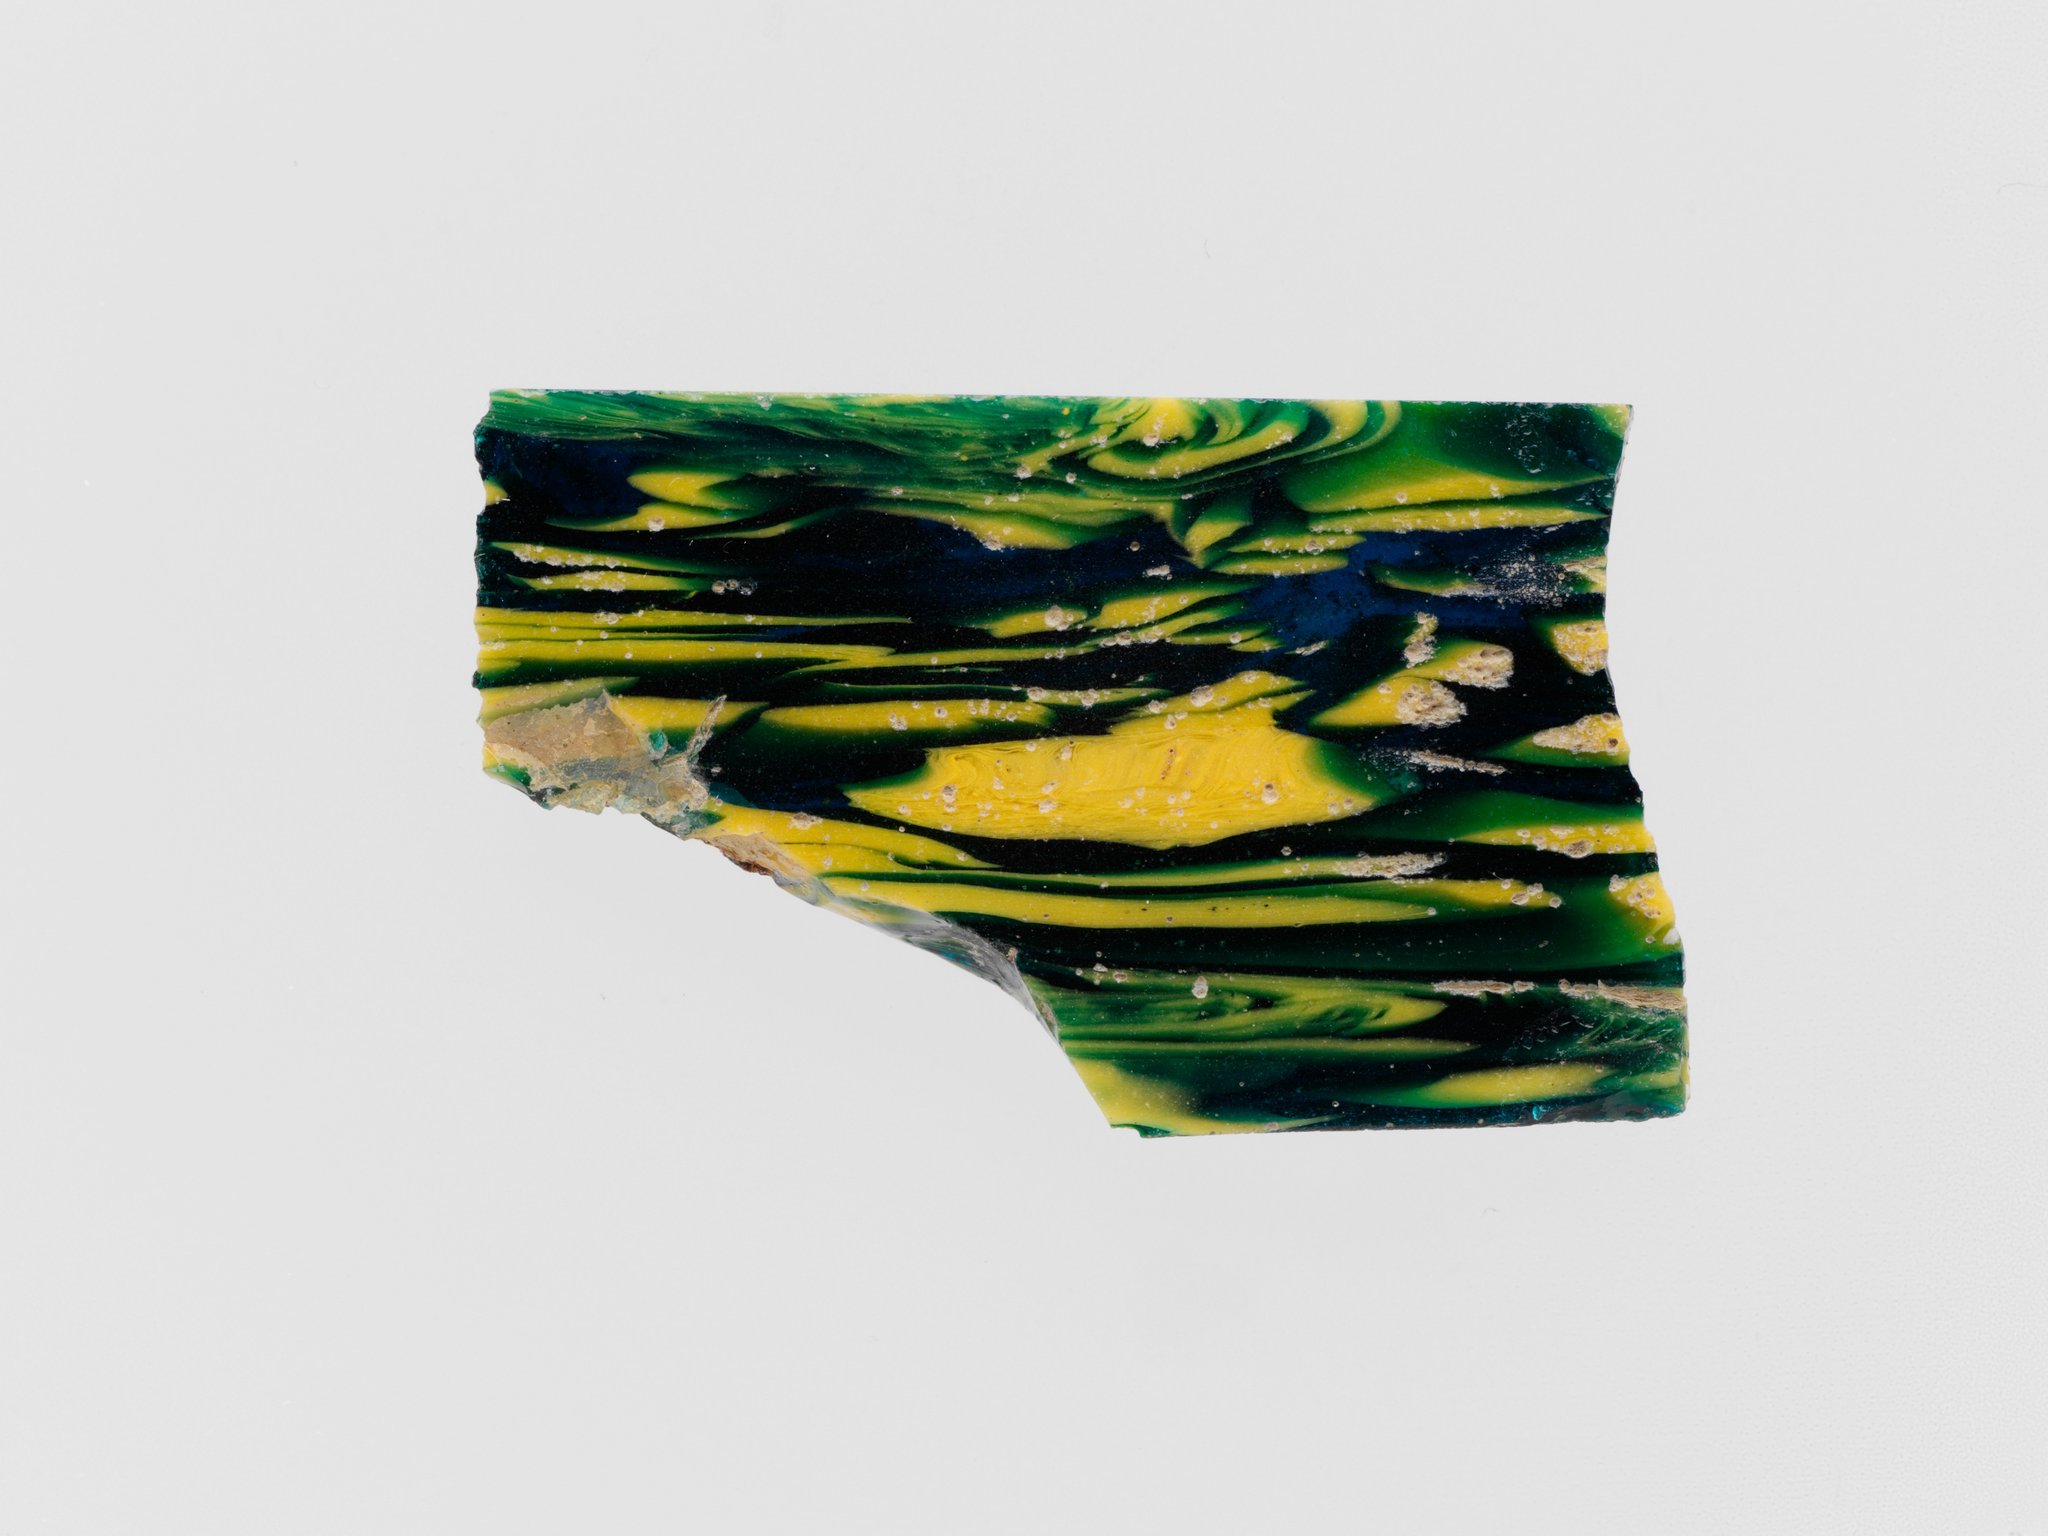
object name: fragment, mosaic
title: Glass mosaic inlay fragment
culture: roman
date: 34 BCE-33 CE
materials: glass